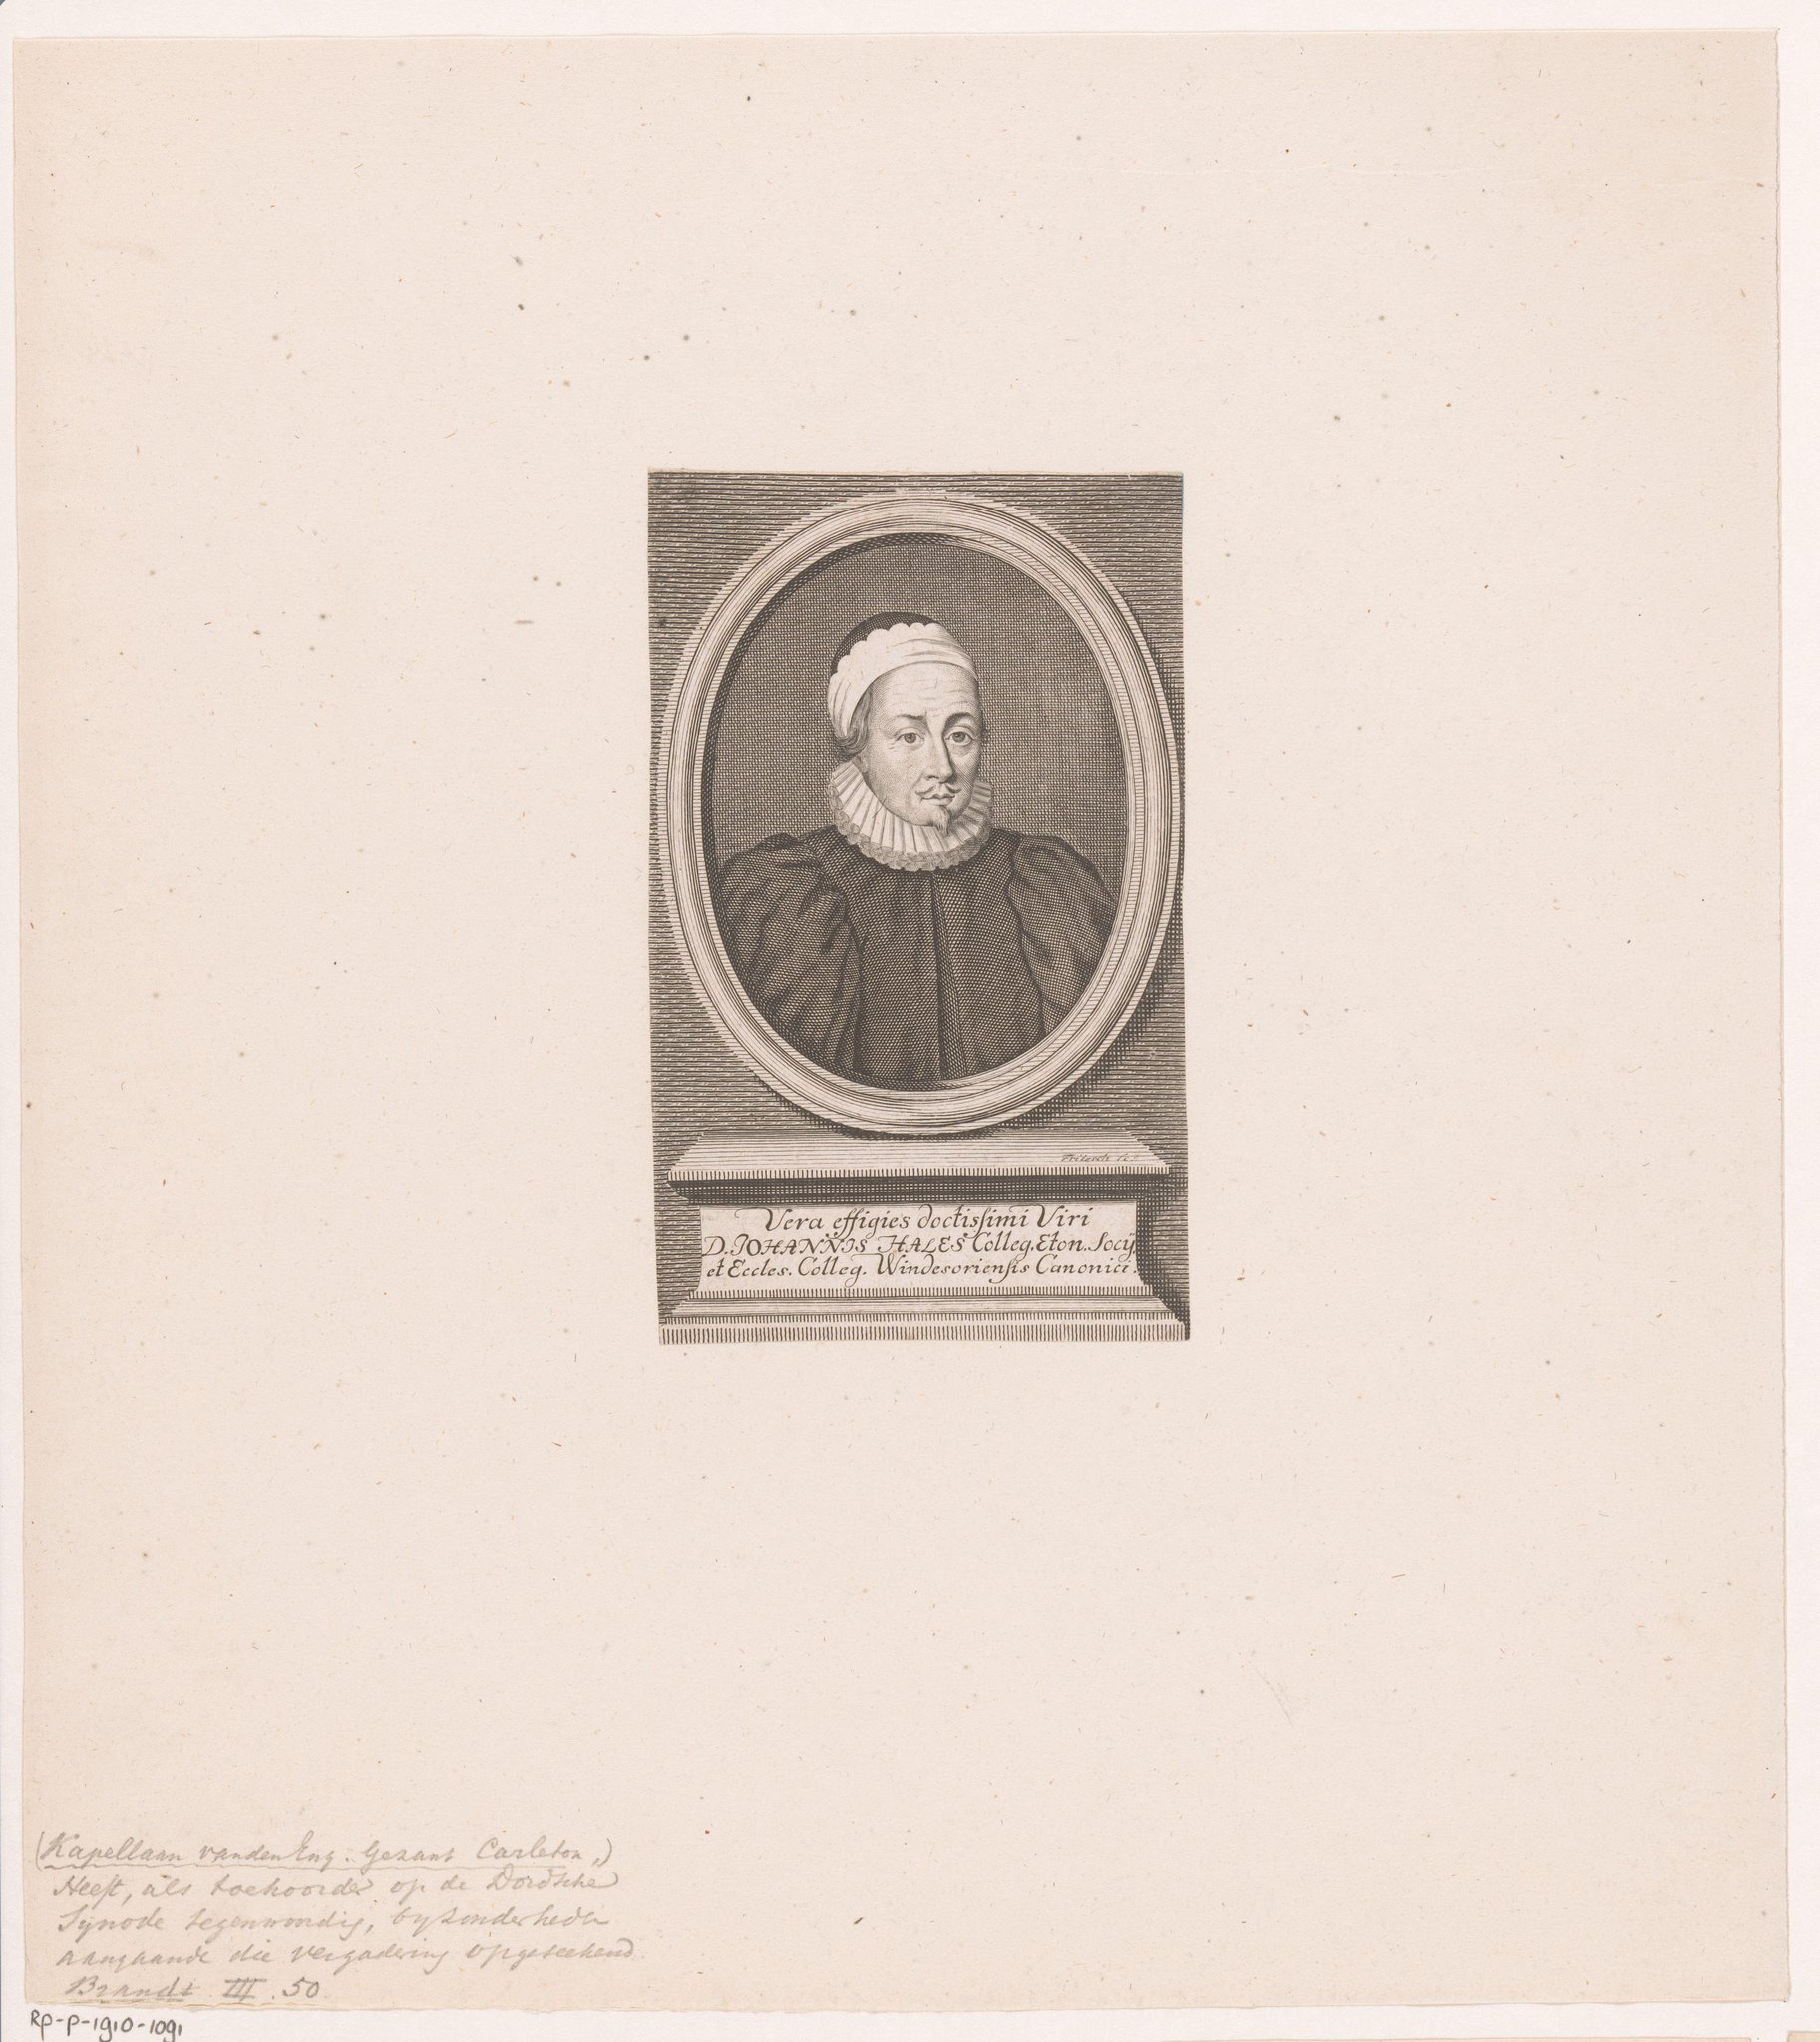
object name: print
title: Portret van John Hales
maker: christian fritzsch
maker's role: print maker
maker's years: 1695-1769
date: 1705-1769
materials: paper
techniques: engraving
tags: ornament ~ medallion, historical persons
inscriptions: collector's mark: Lugt 2228